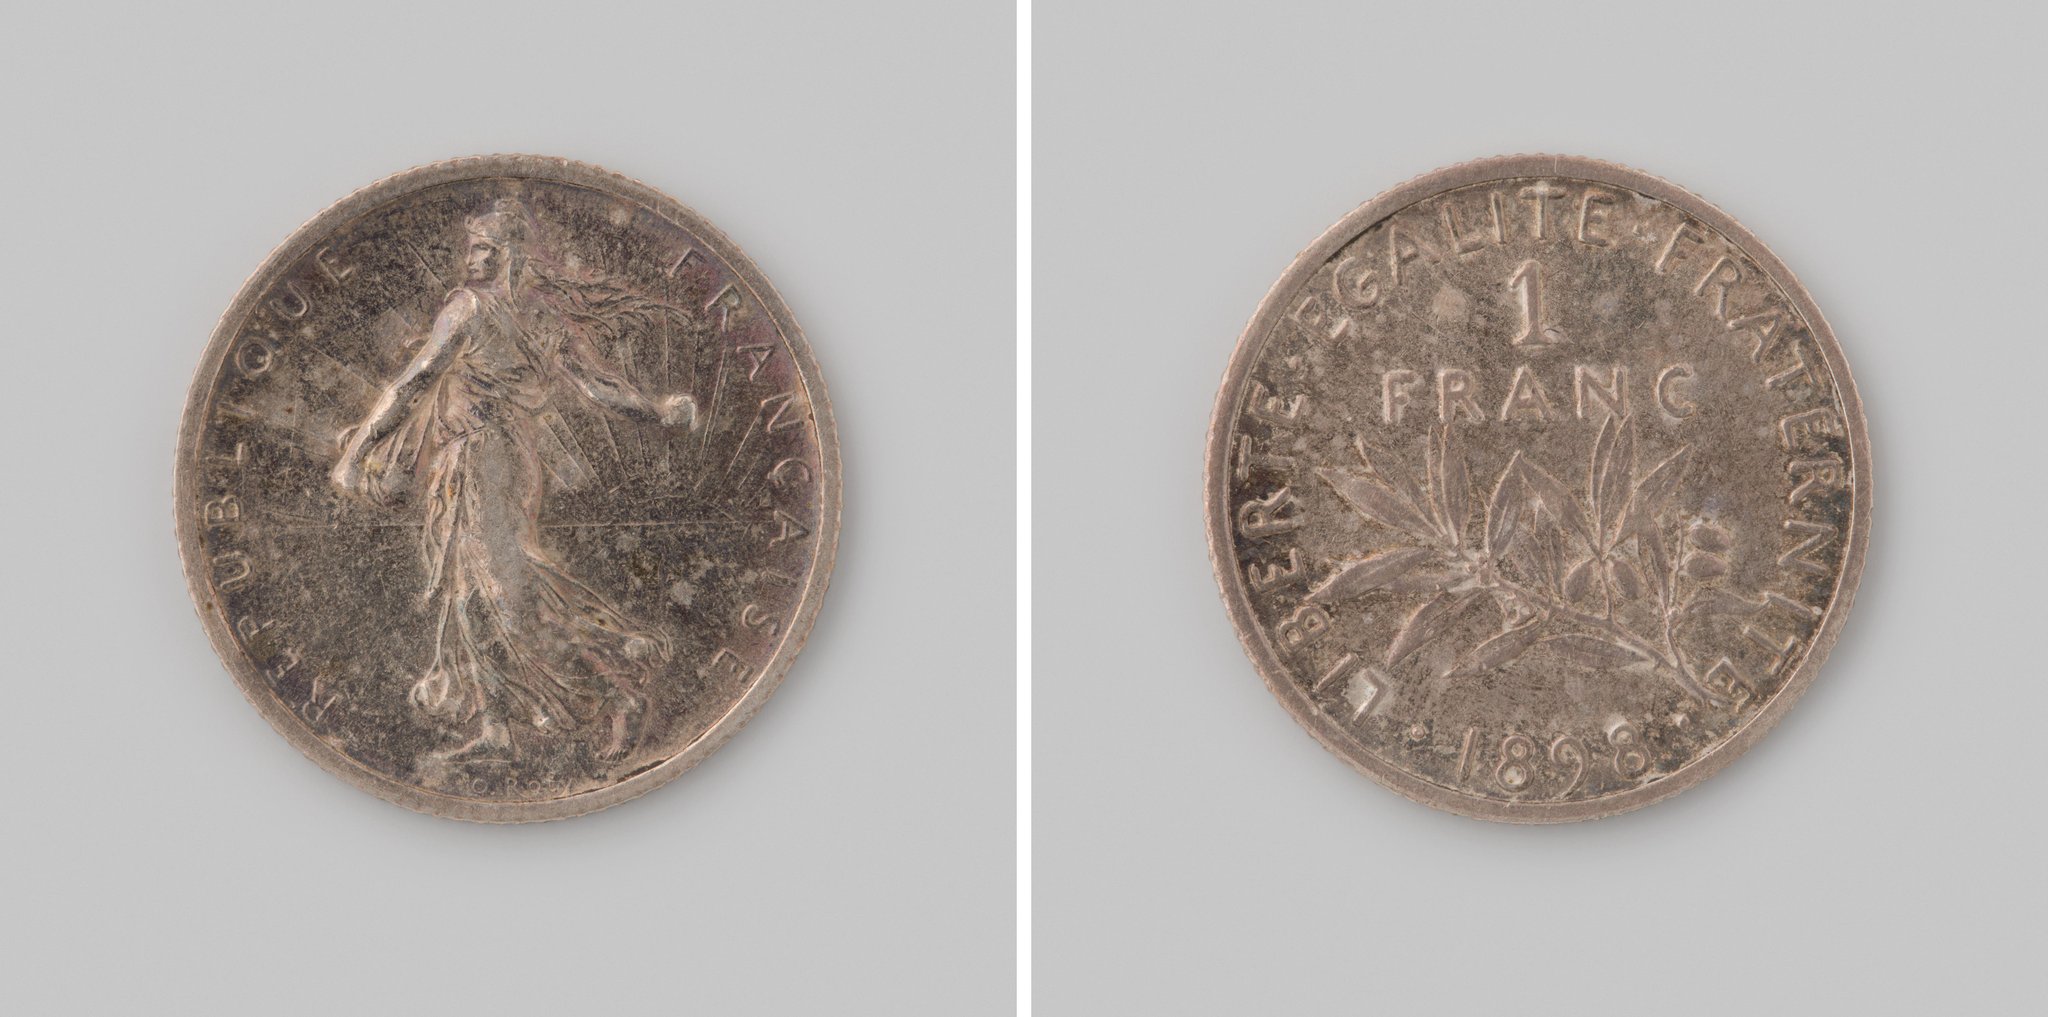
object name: coin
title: Franc uit Frankrijk, de Derde Republiek, 1898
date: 1898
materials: silver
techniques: striking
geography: paris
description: Zilveren munt. Voorzijde: zaaiende vrouw met vrijheidshoed naar links met op achtergrond stralende zon. Keerzijde: waarde-aanduiding in twee regels, waaronder tak. Jaartal onderaan in omschrift. Kartelrand.